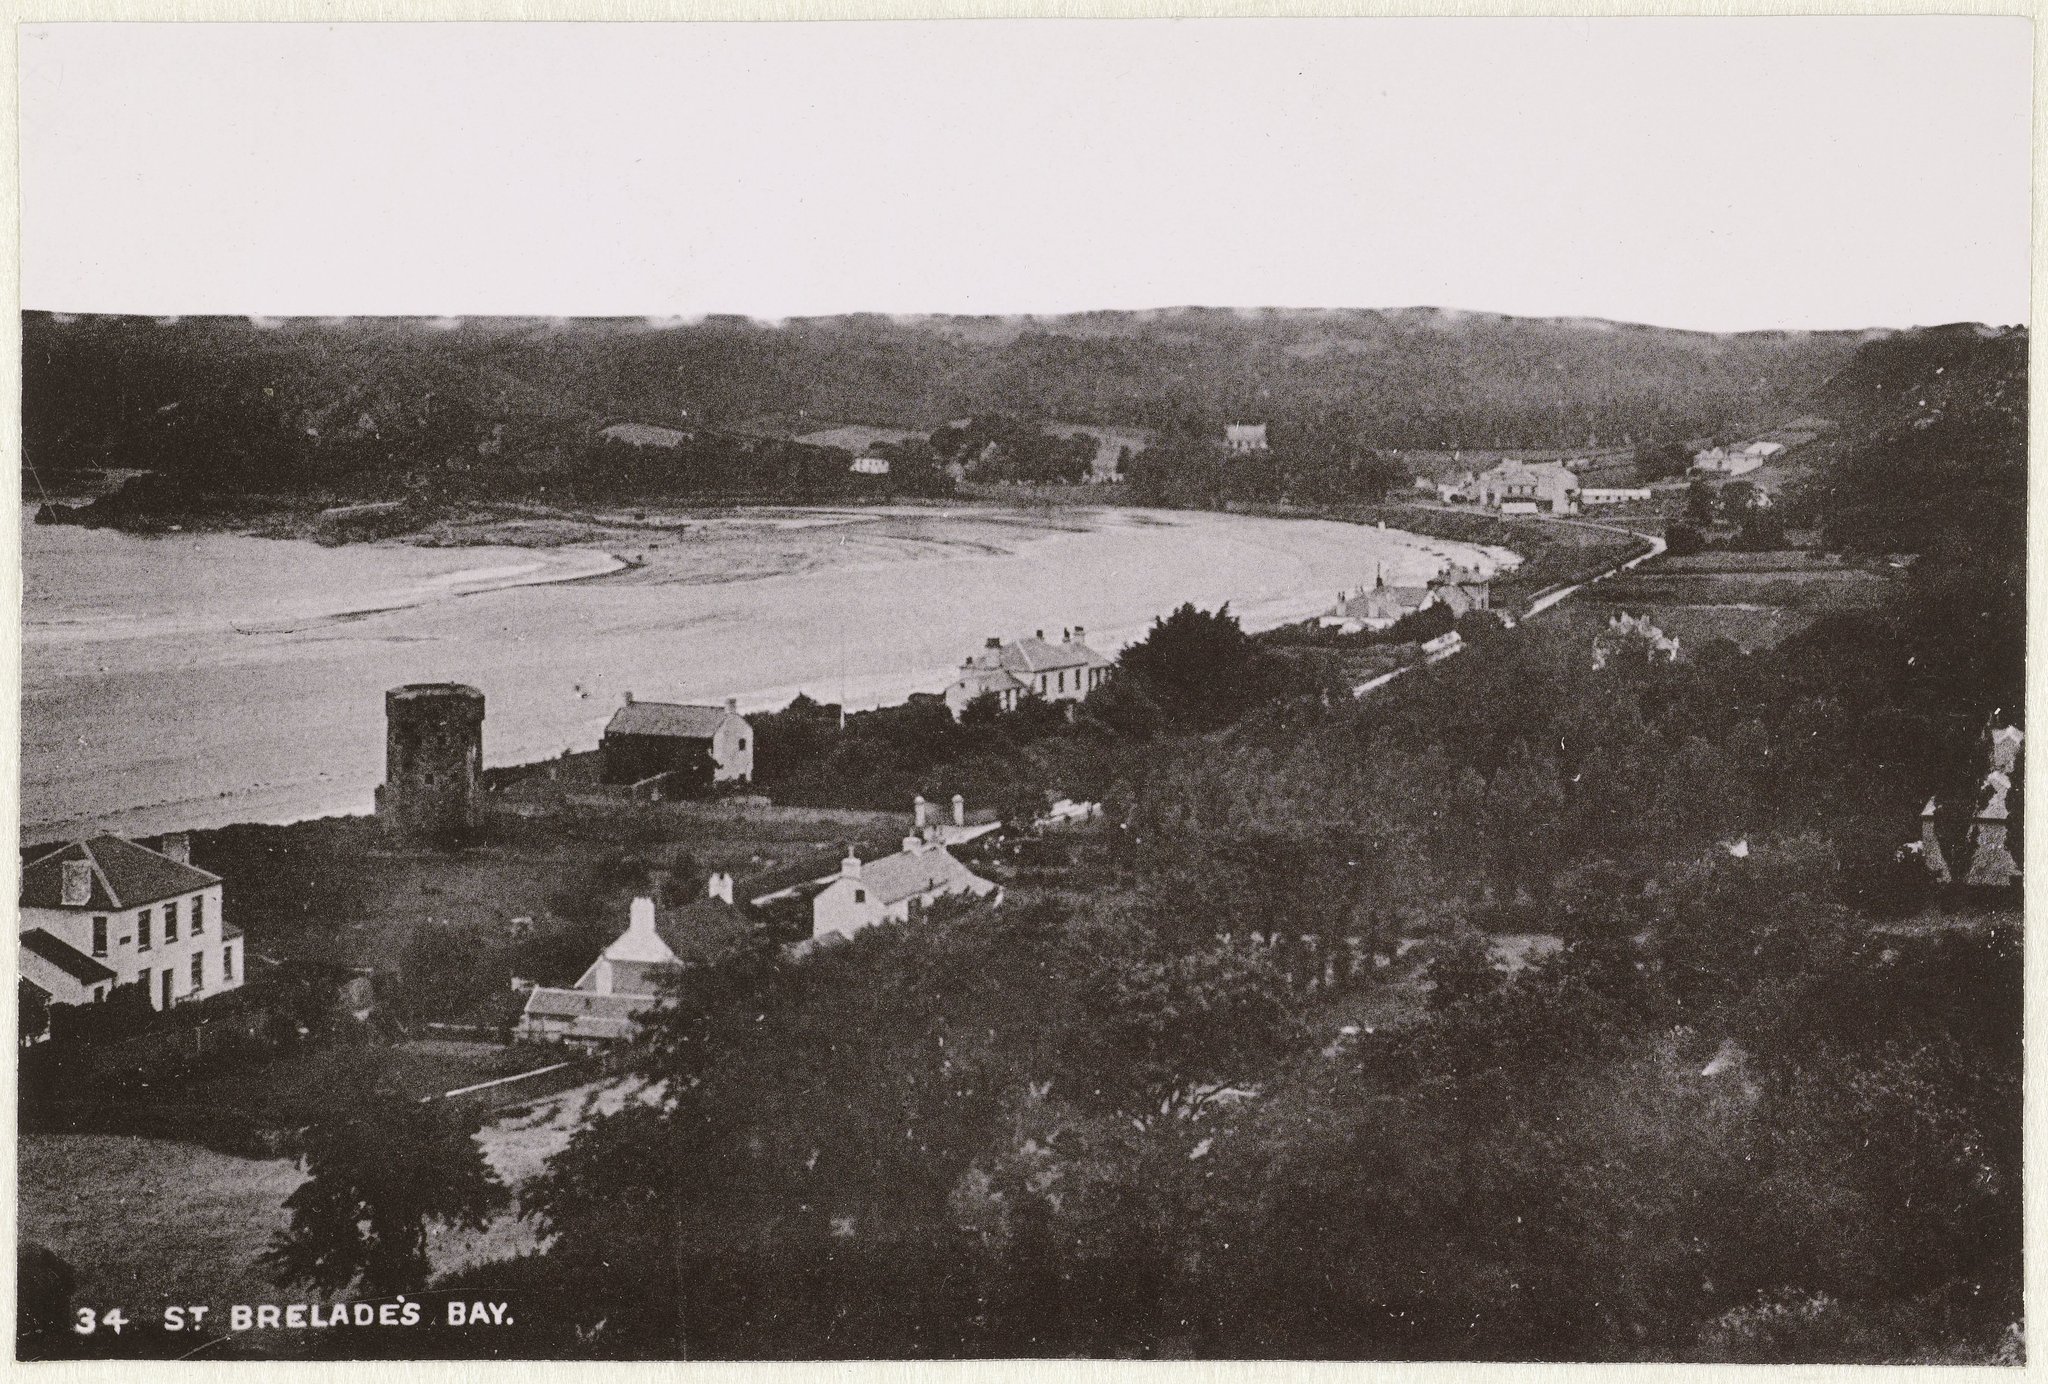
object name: photomechanical print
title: Baai in Saint Brelade op Jersey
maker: Anonymous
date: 1870-1930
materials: paper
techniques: photograph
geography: jersey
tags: gulf, bay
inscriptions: number: ‘34’